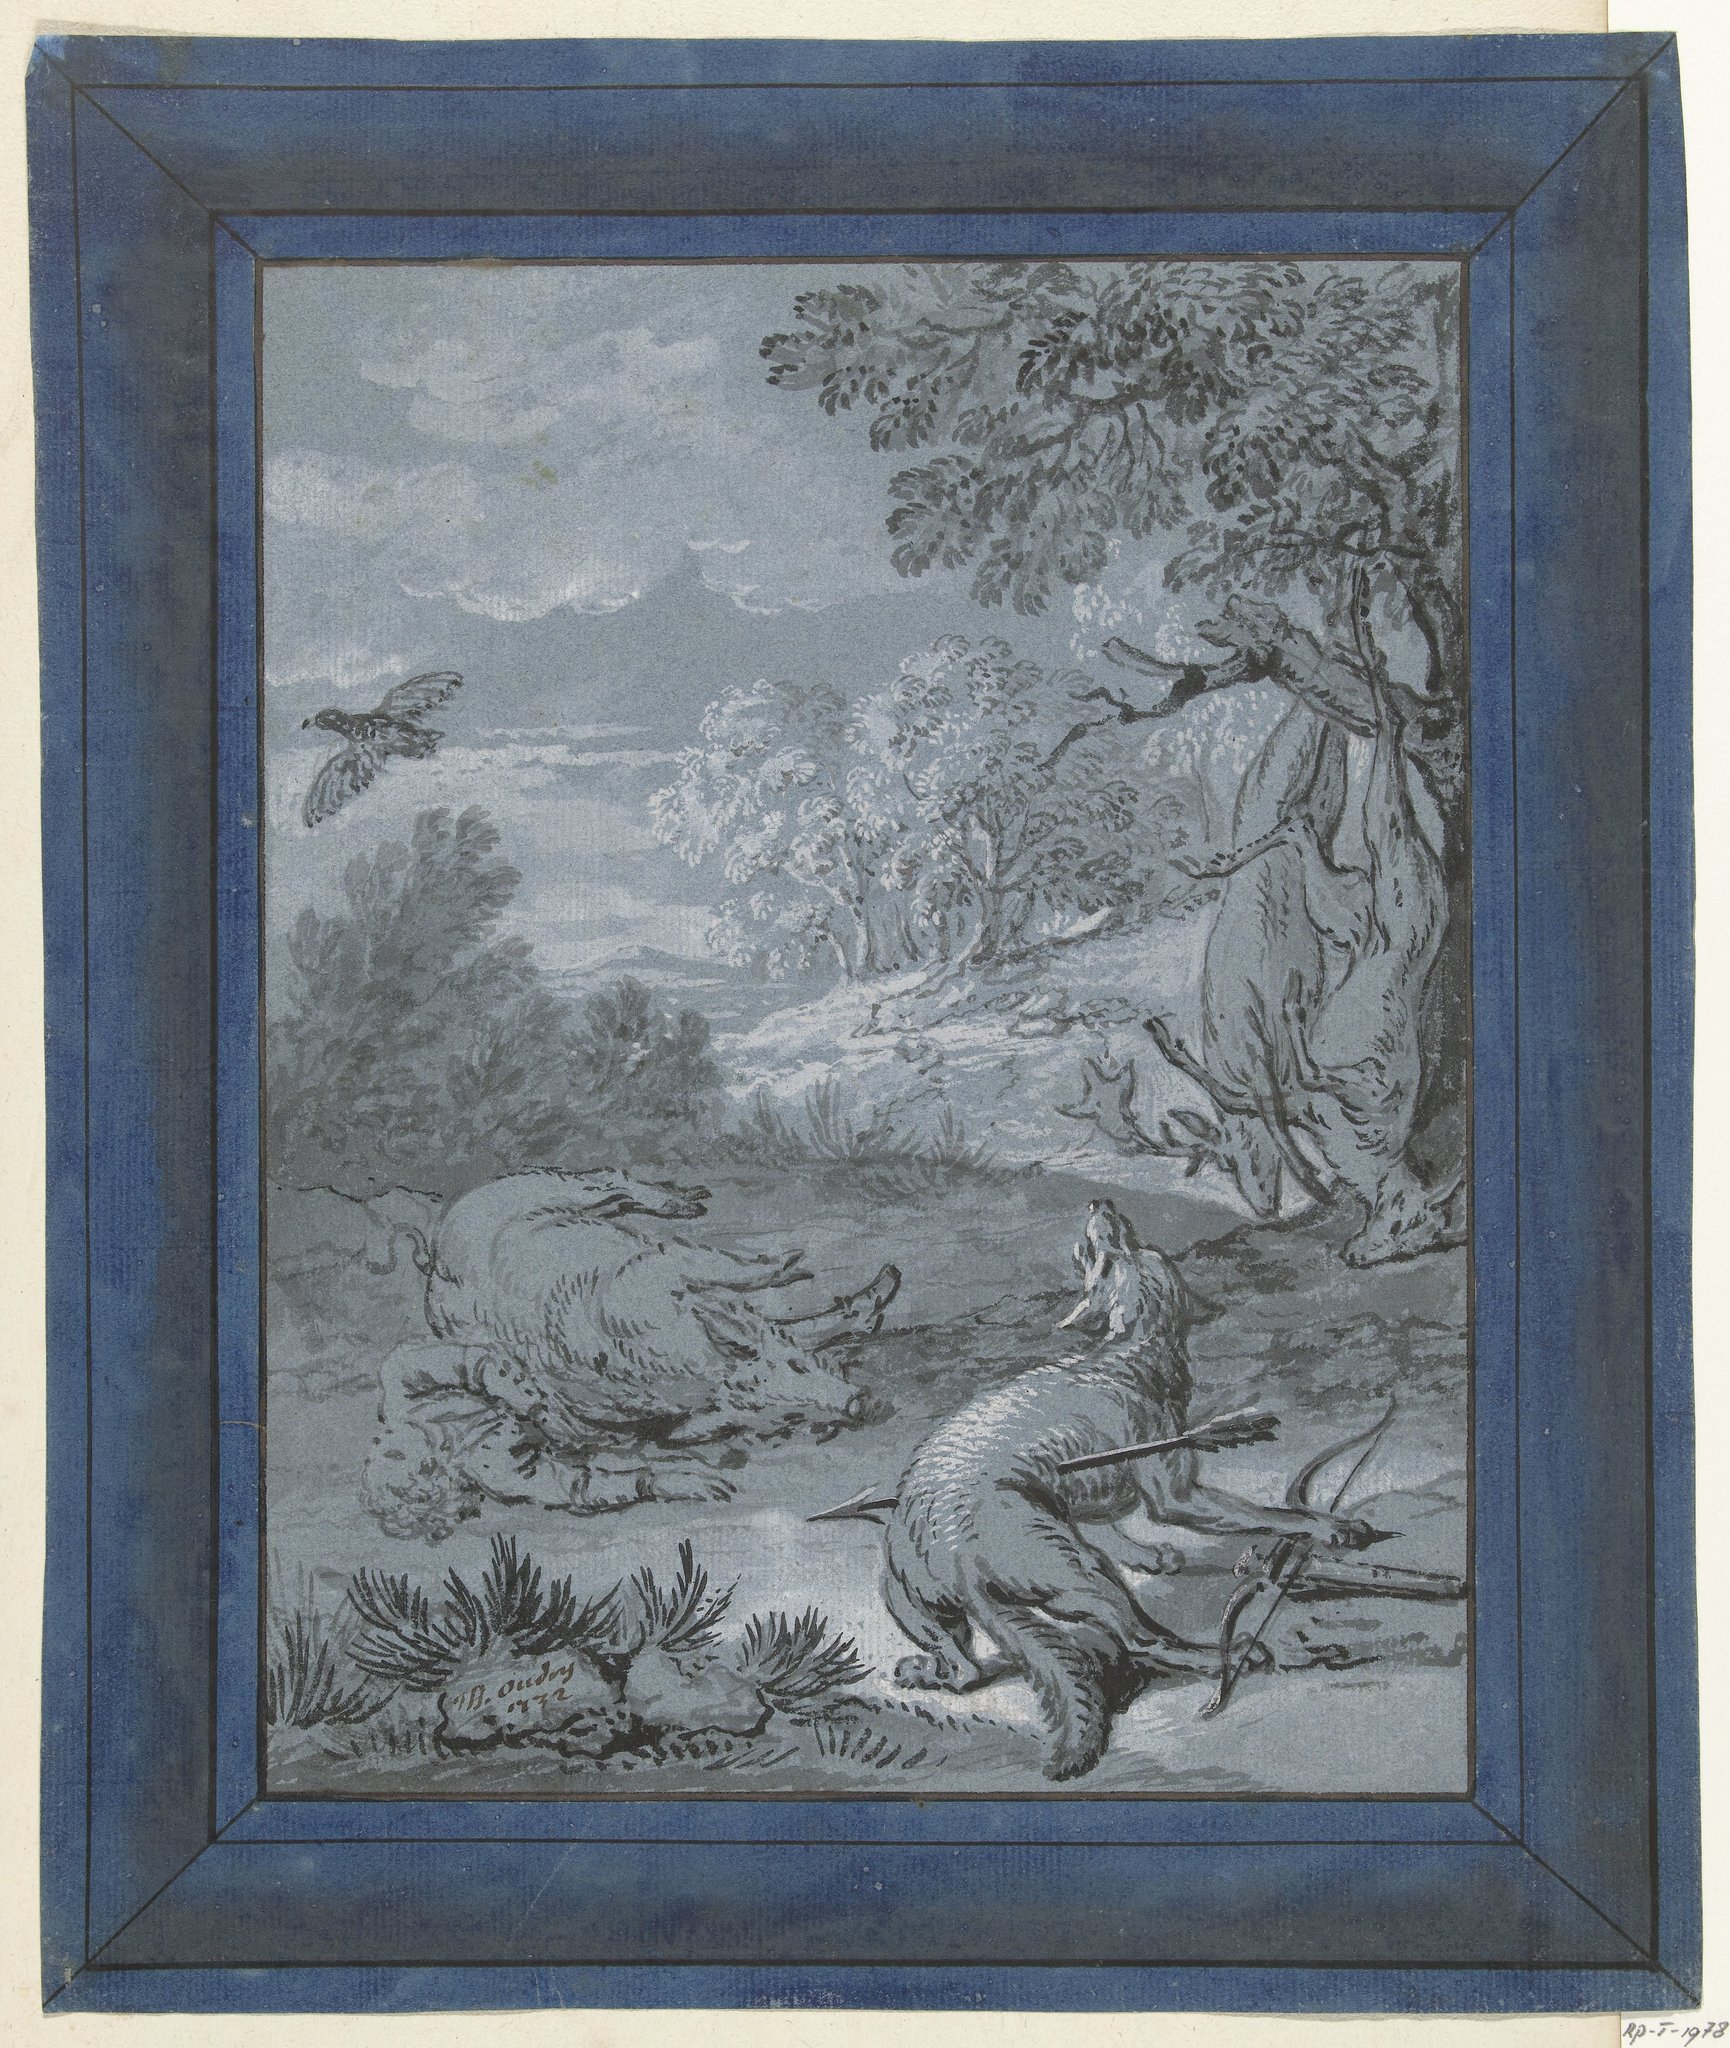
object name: design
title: Illustraties voor fabels van Jean de la Fontaine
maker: jean-baptiste oudry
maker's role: draughtsman, print maker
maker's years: 1686-1755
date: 1732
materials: paper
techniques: brush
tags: beasts of prey, predatory animals: wolf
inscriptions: signature and date, recto, lower left: ‘J.B. Oudry // 1732’, collector's mark, verso, lower centre: Lugt 2228, annotation, verso, on the old mount, upper centre, pen and brown ink: ‘45. t. 2e’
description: Een wolf bij een jager die onder een wild zwijn ligt. Aan een boom hangen twee gedode herten. Ontwerp voor een prent.